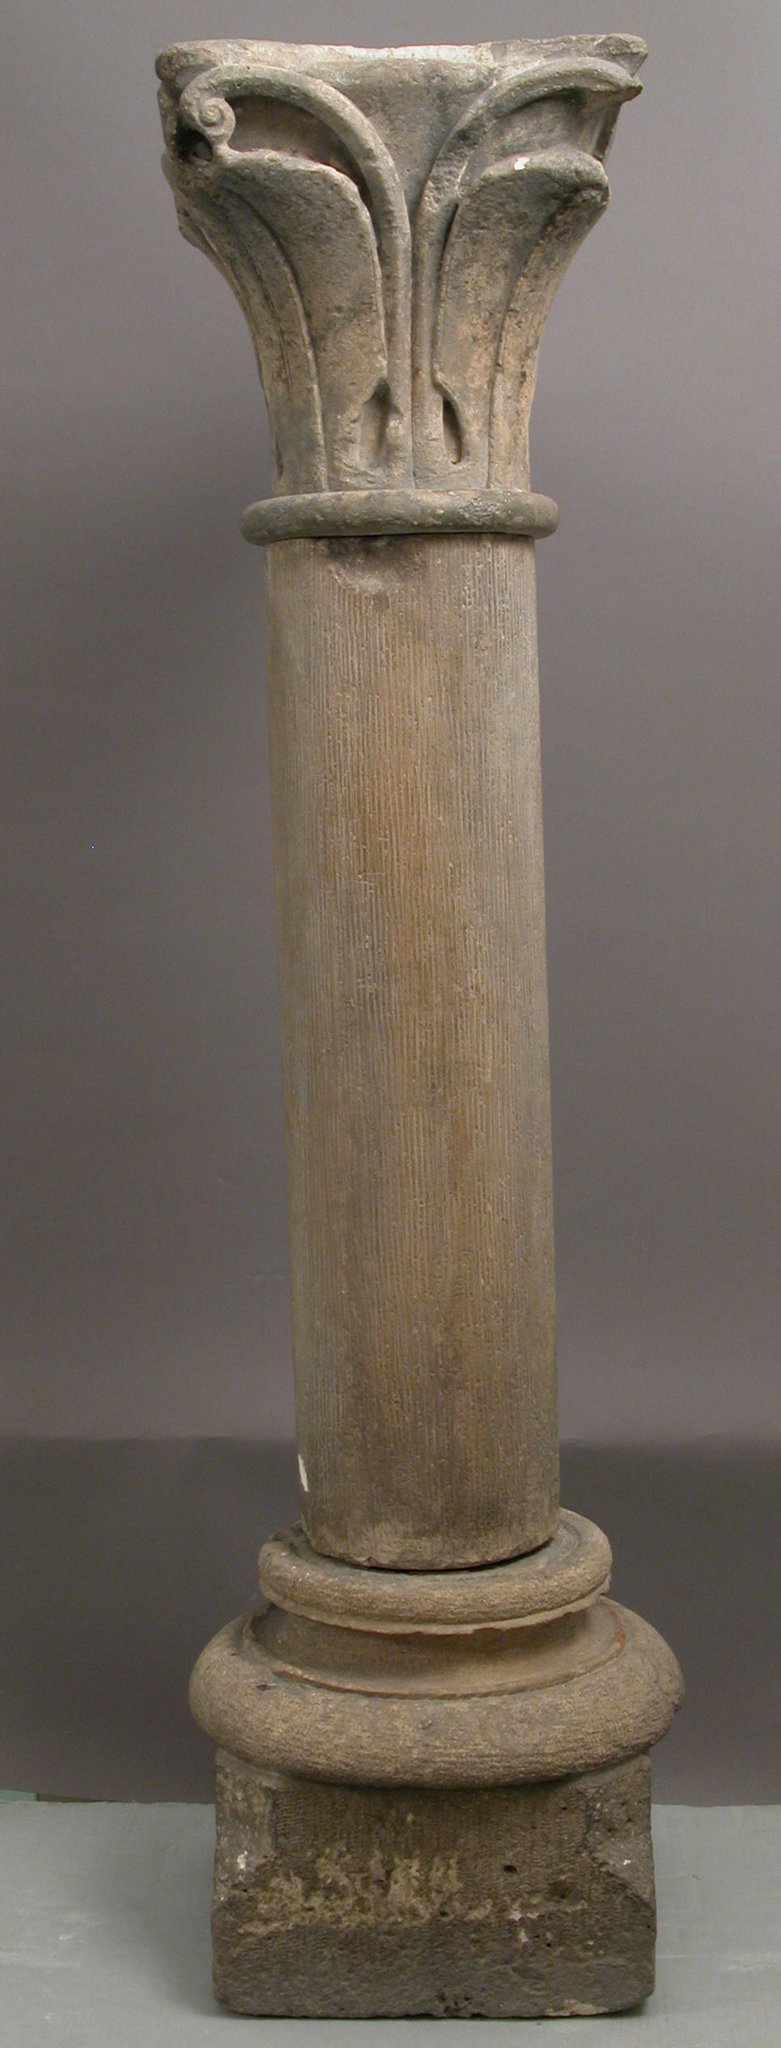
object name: column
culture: french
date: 1101-1300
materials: limestone